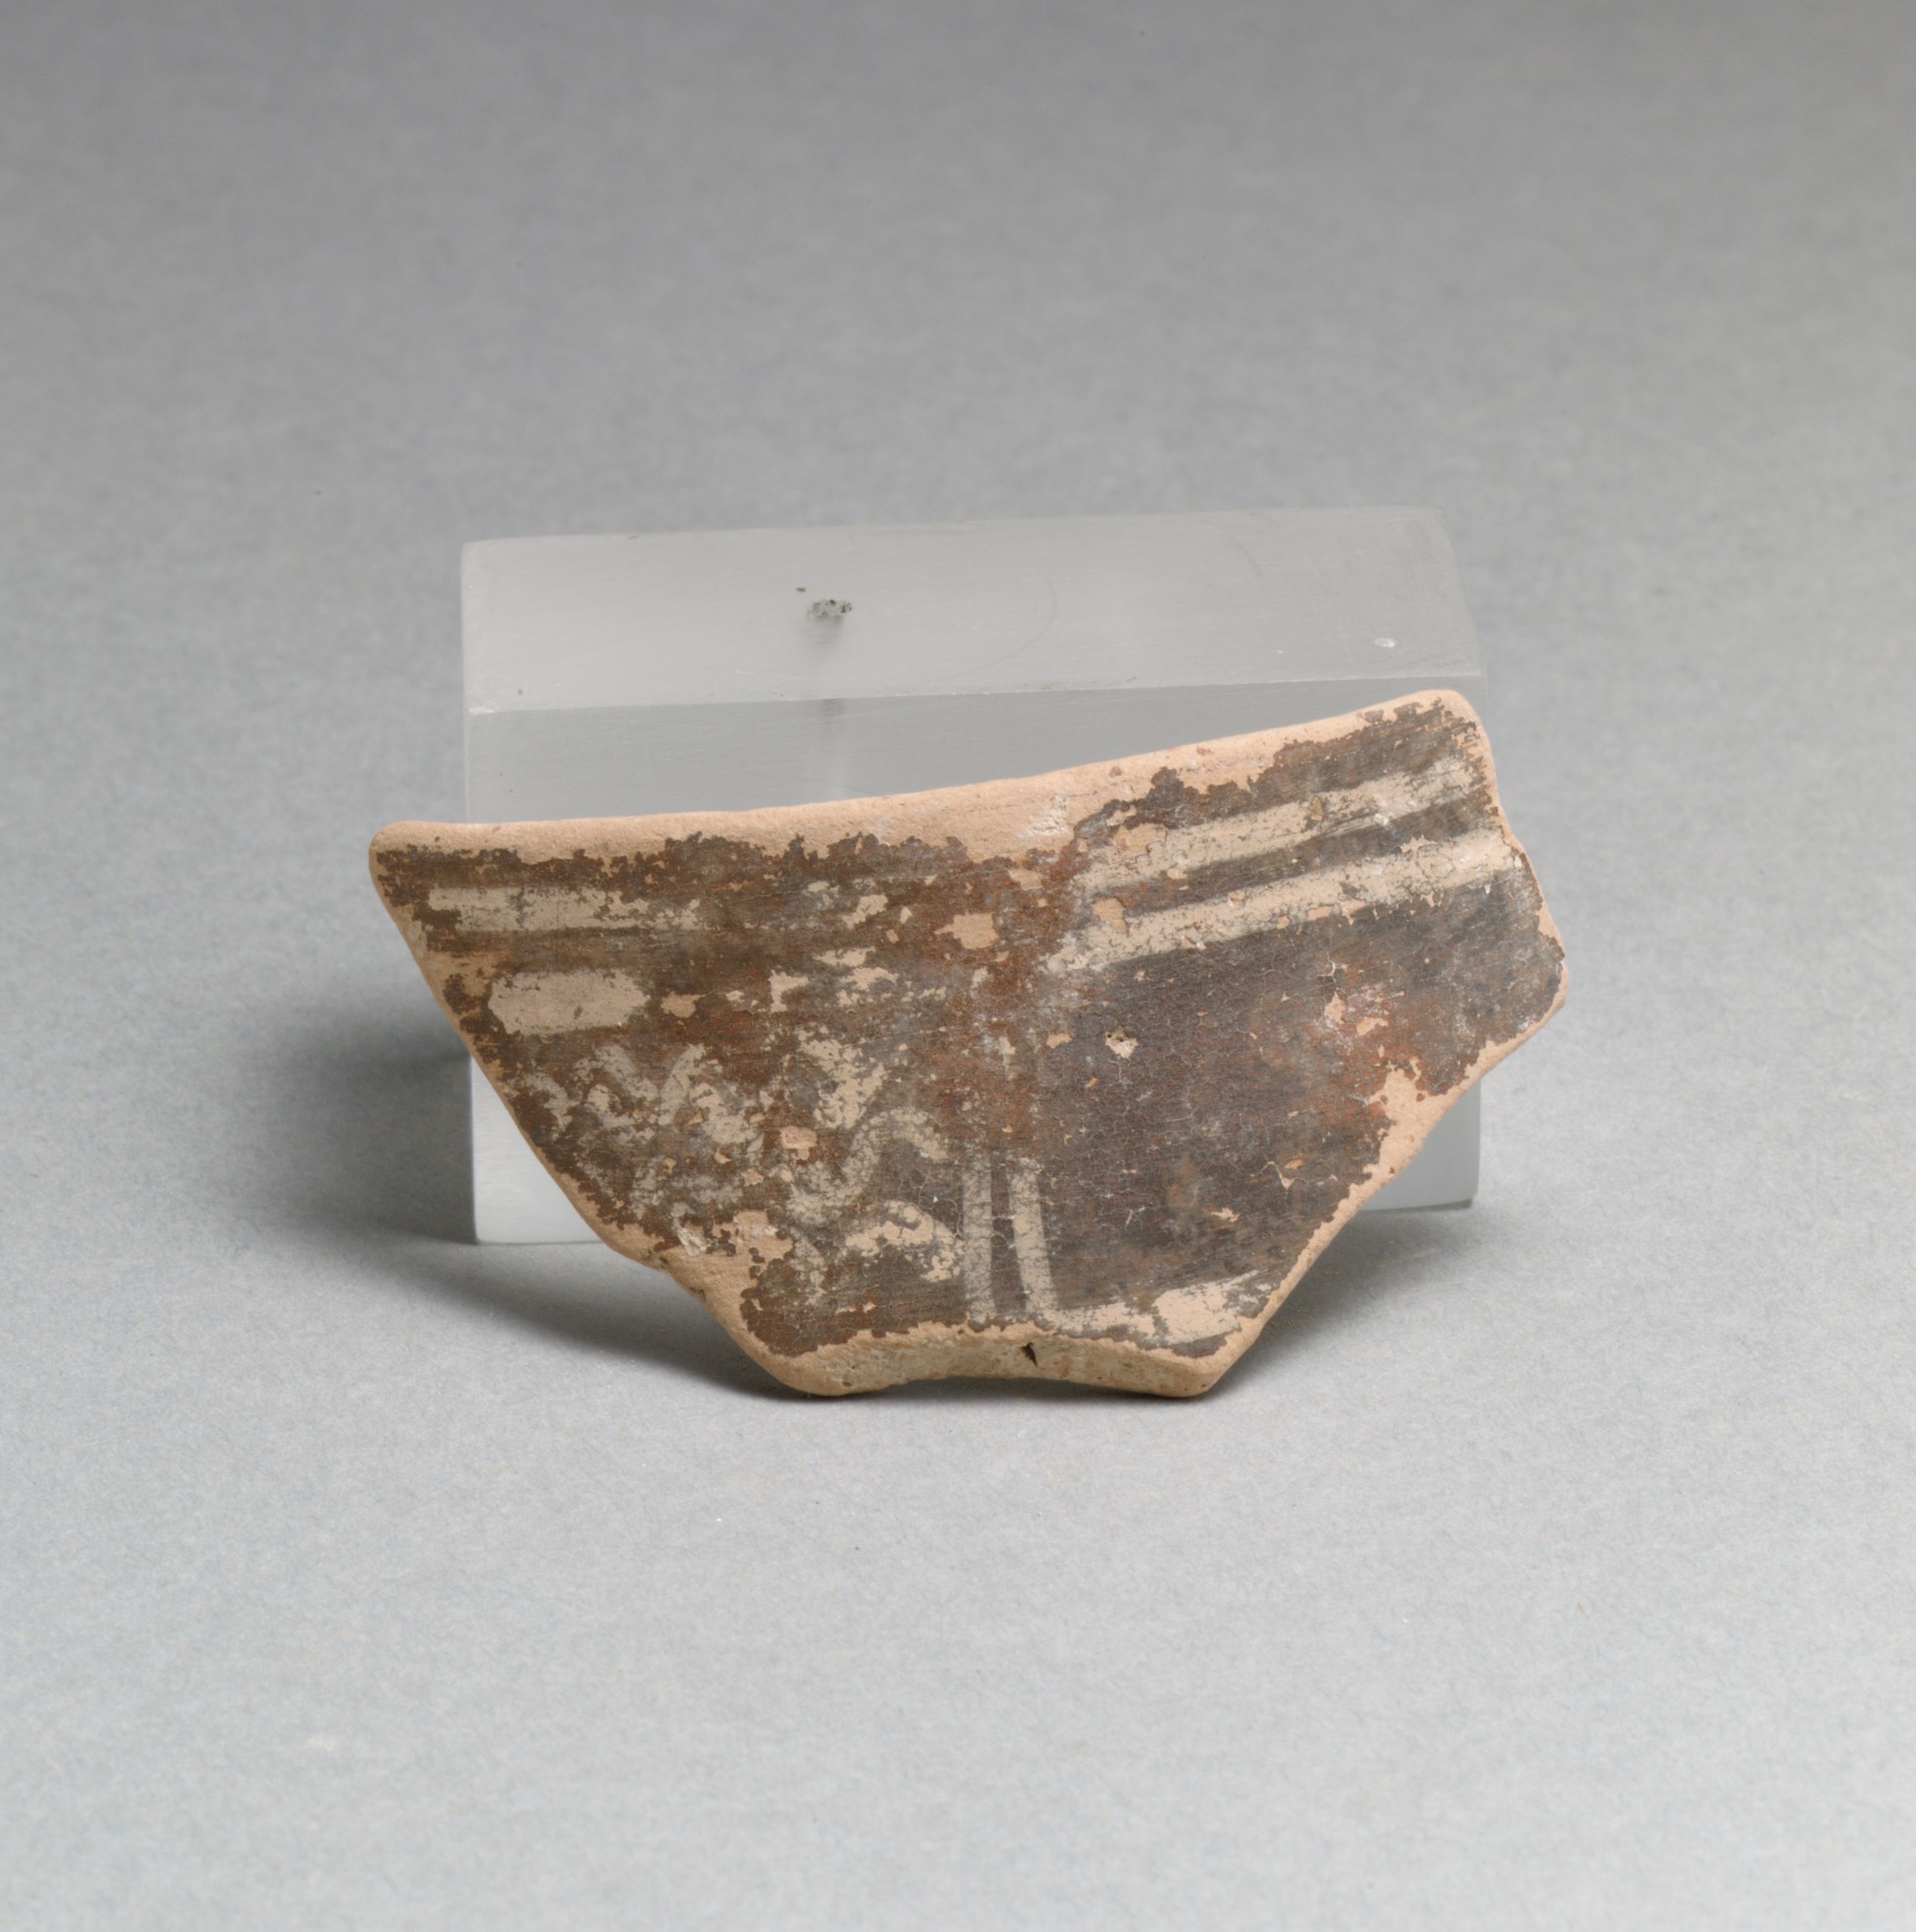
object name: vase fragment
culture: minoan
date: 2600-2000 BCE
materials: terracotta